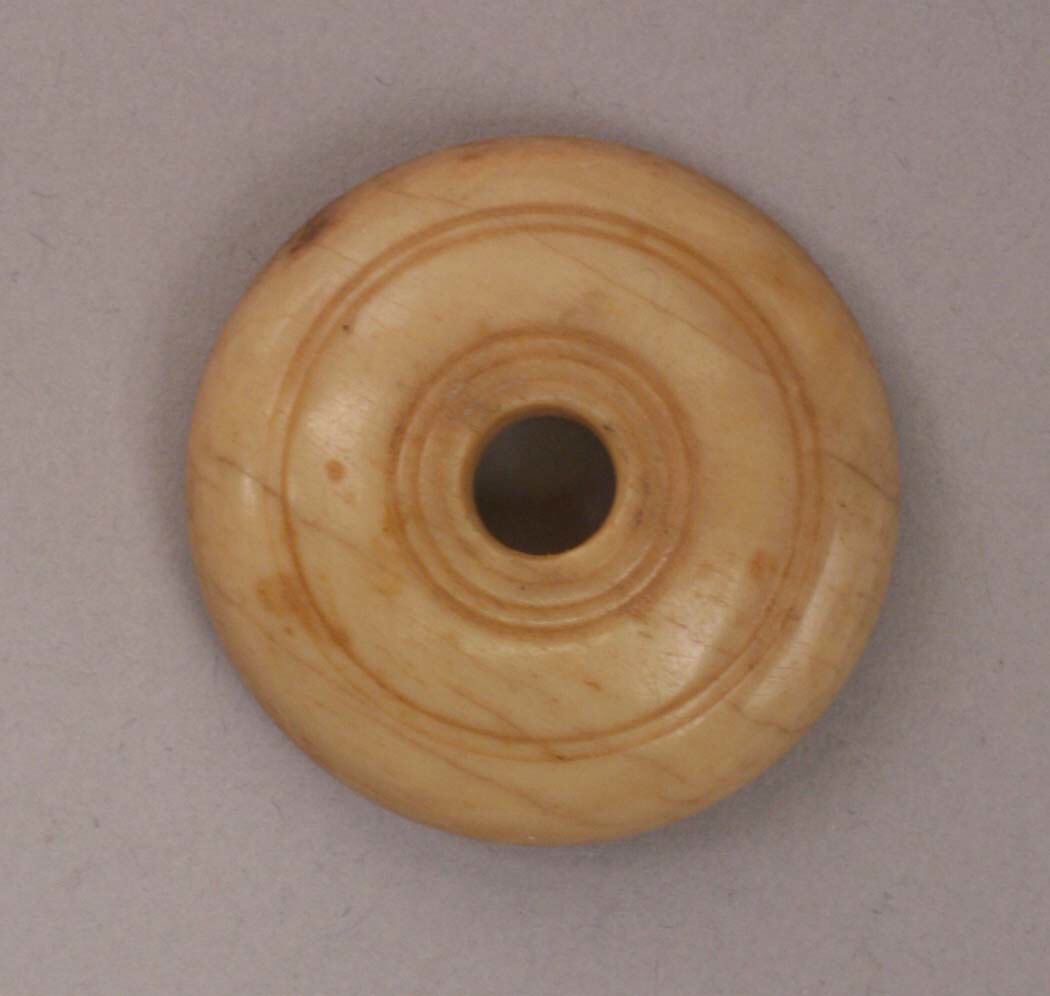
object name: button or bead or spindle whorl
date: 801-1000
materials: bone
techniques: incising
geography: iran